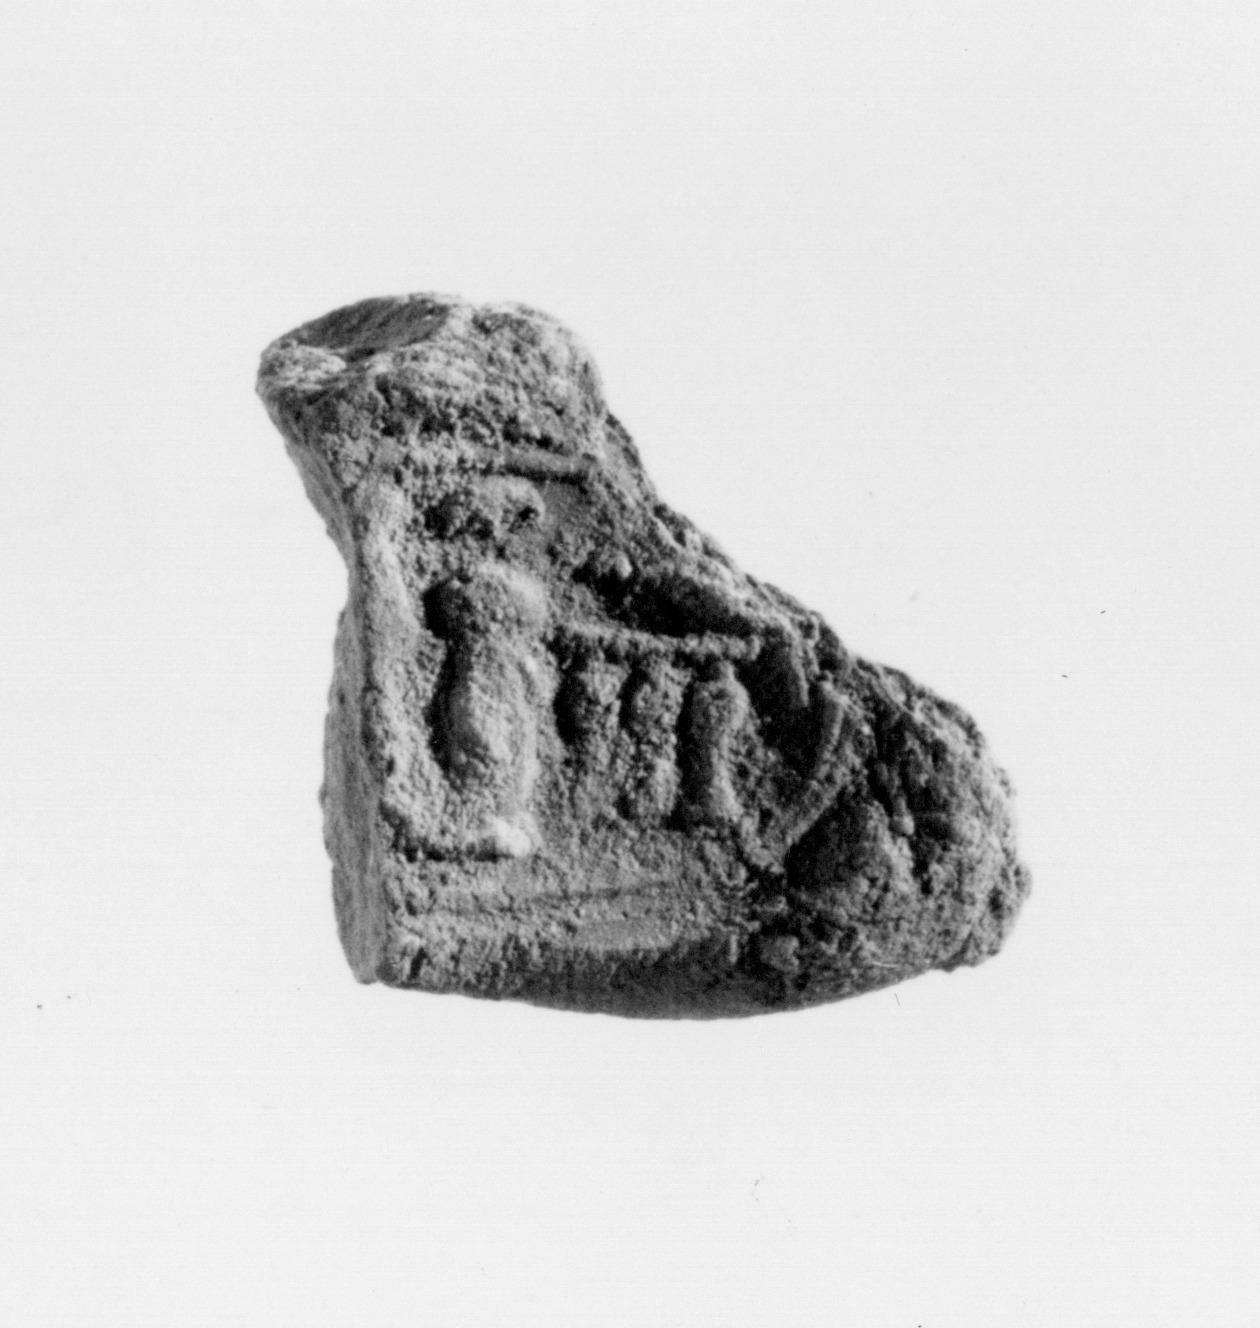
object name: sealing, nebmaatre, amenhotep iii,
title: Document Sealing With the Throne Name of Amenhotep III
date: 1390-1352 BCE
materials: mud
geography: egypt